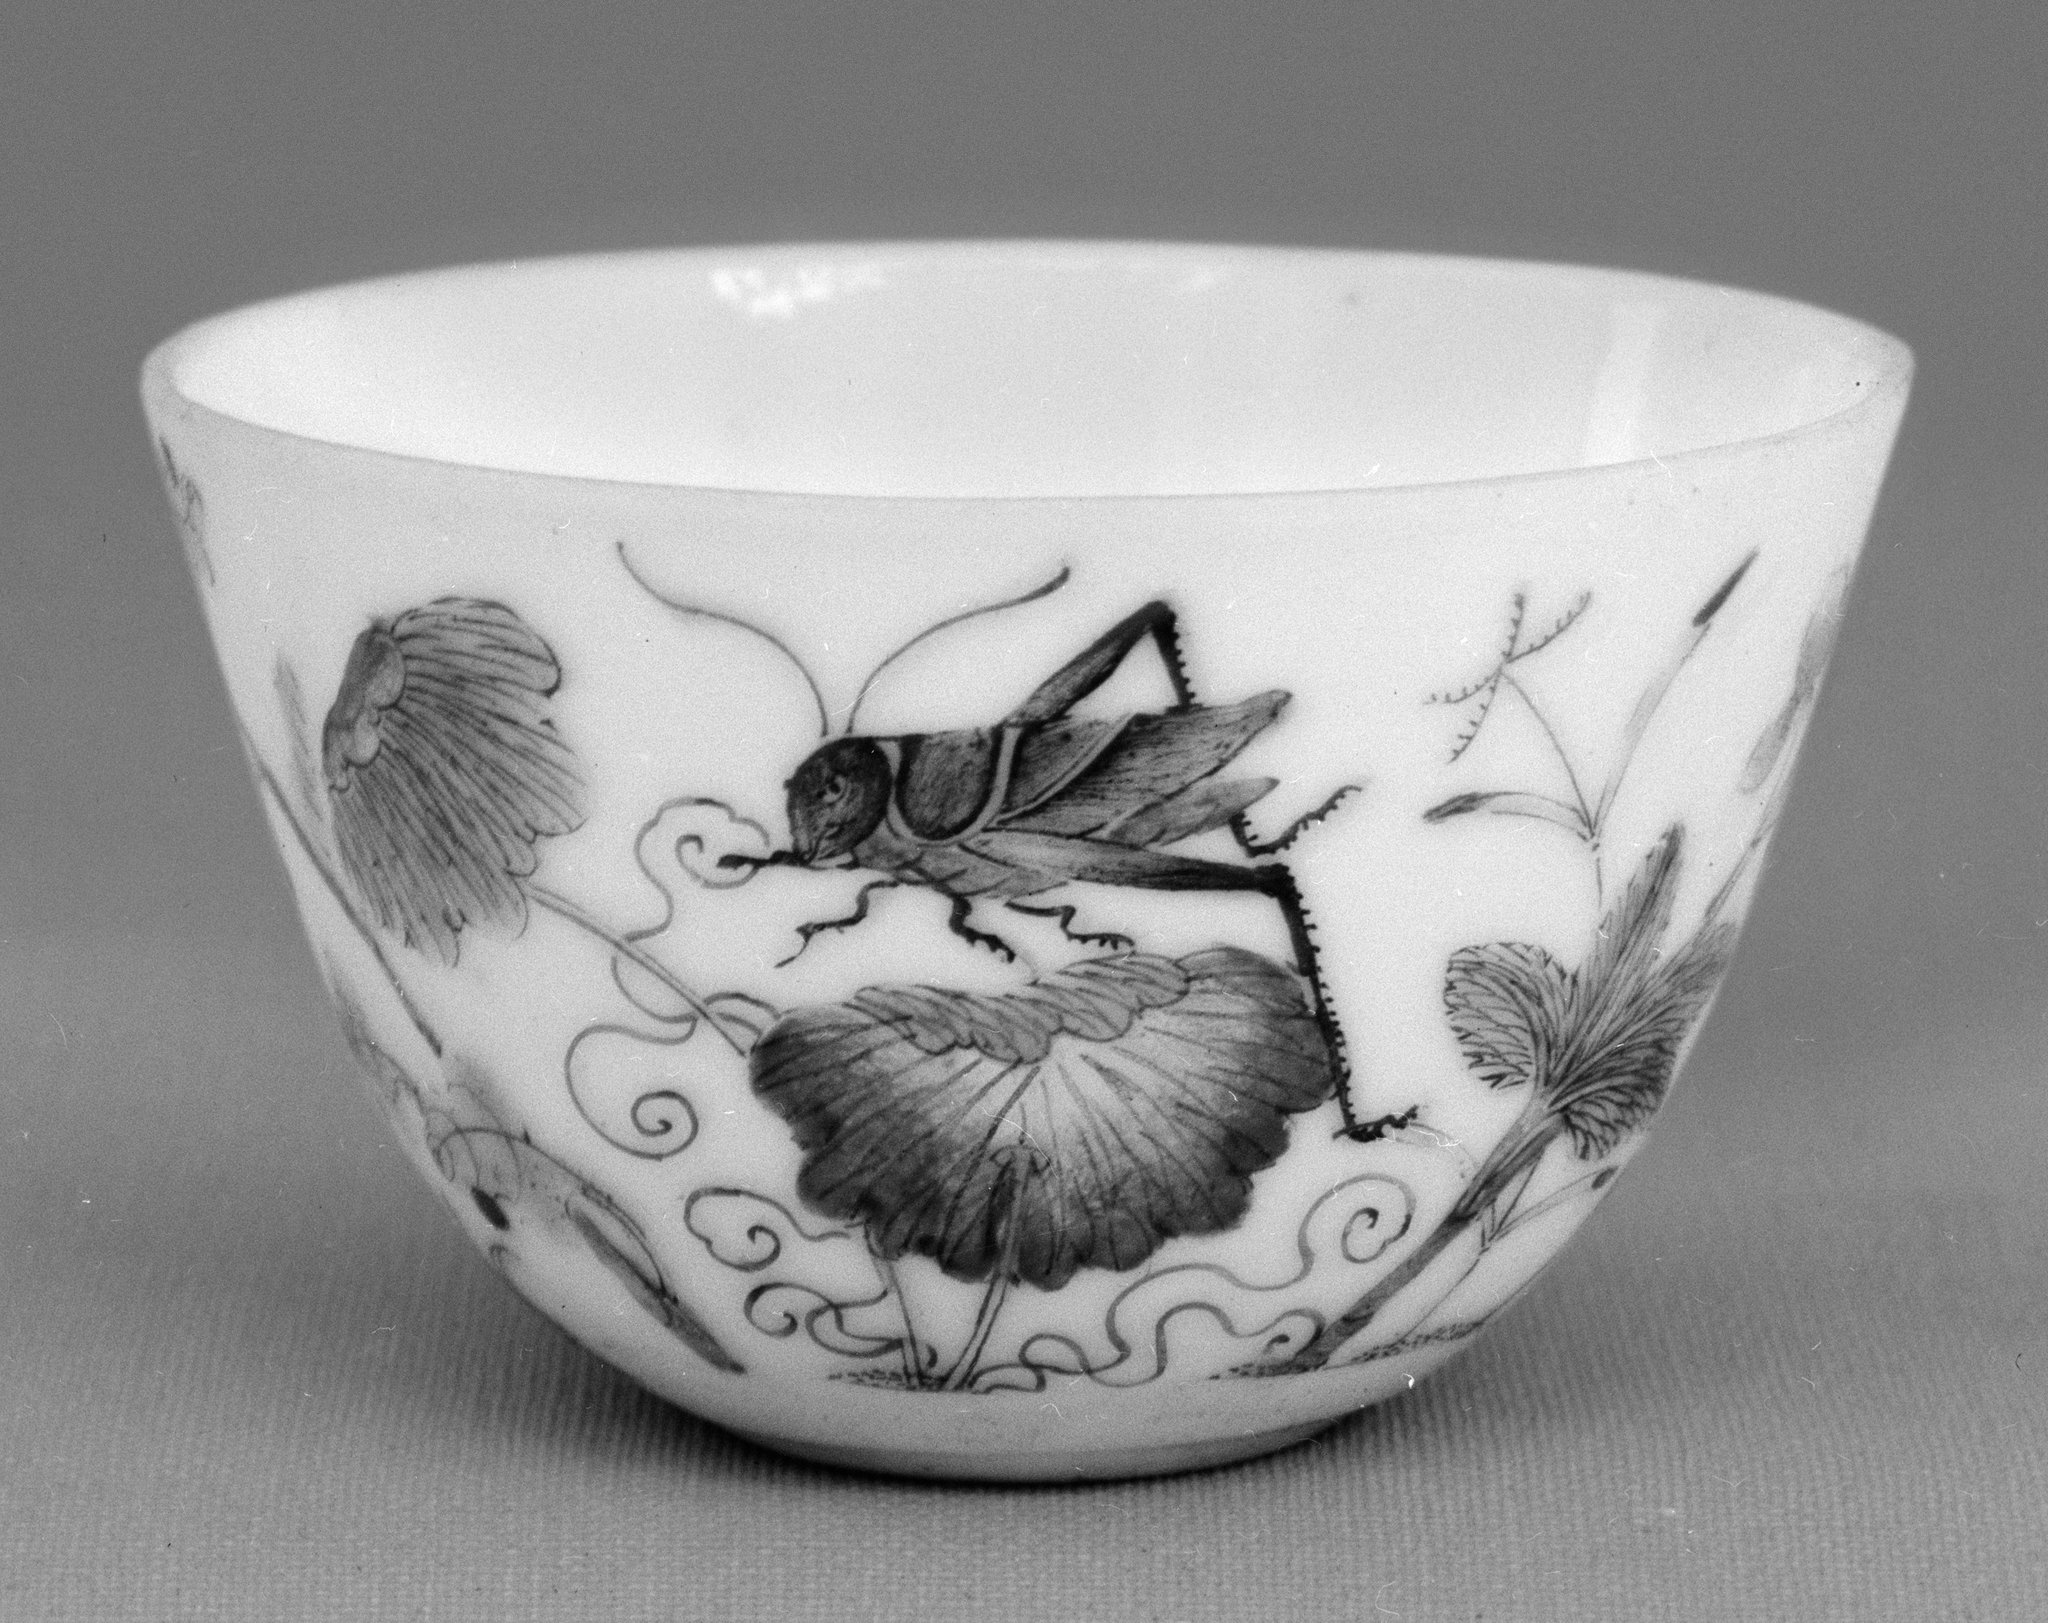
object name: cup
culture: chinese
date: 1801-1900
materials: enamel, porcelain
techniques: overglaze, painting, polychrome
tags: insects,flowers